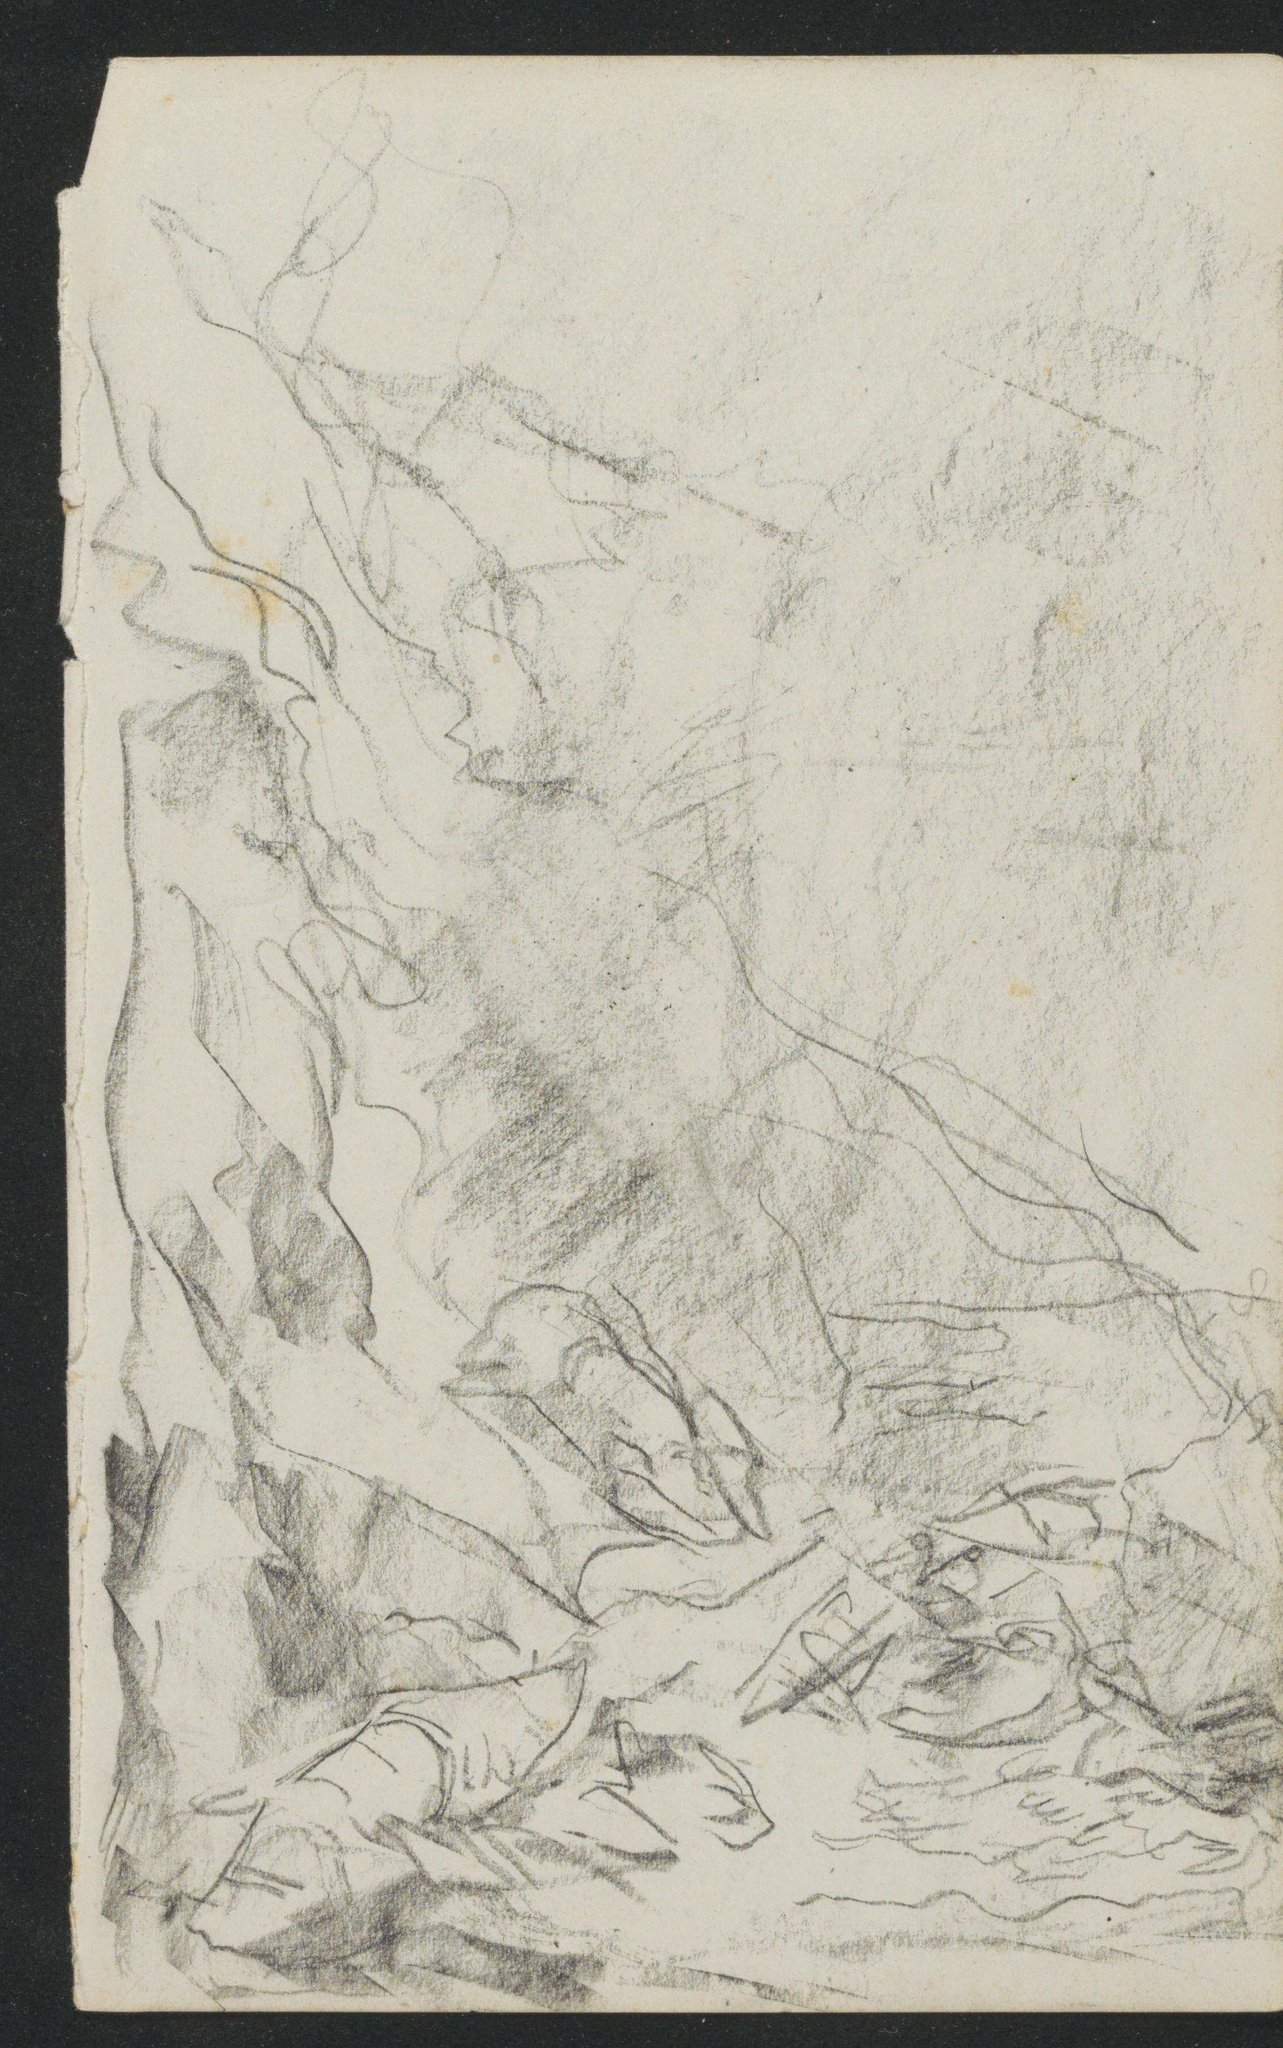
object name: drawing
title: Rotswand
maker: gerrit willem dijsselhof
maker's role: designer, draughtsman, print maker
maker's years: 1866-1924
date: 1876-1924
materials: chalk, paper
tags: rocks